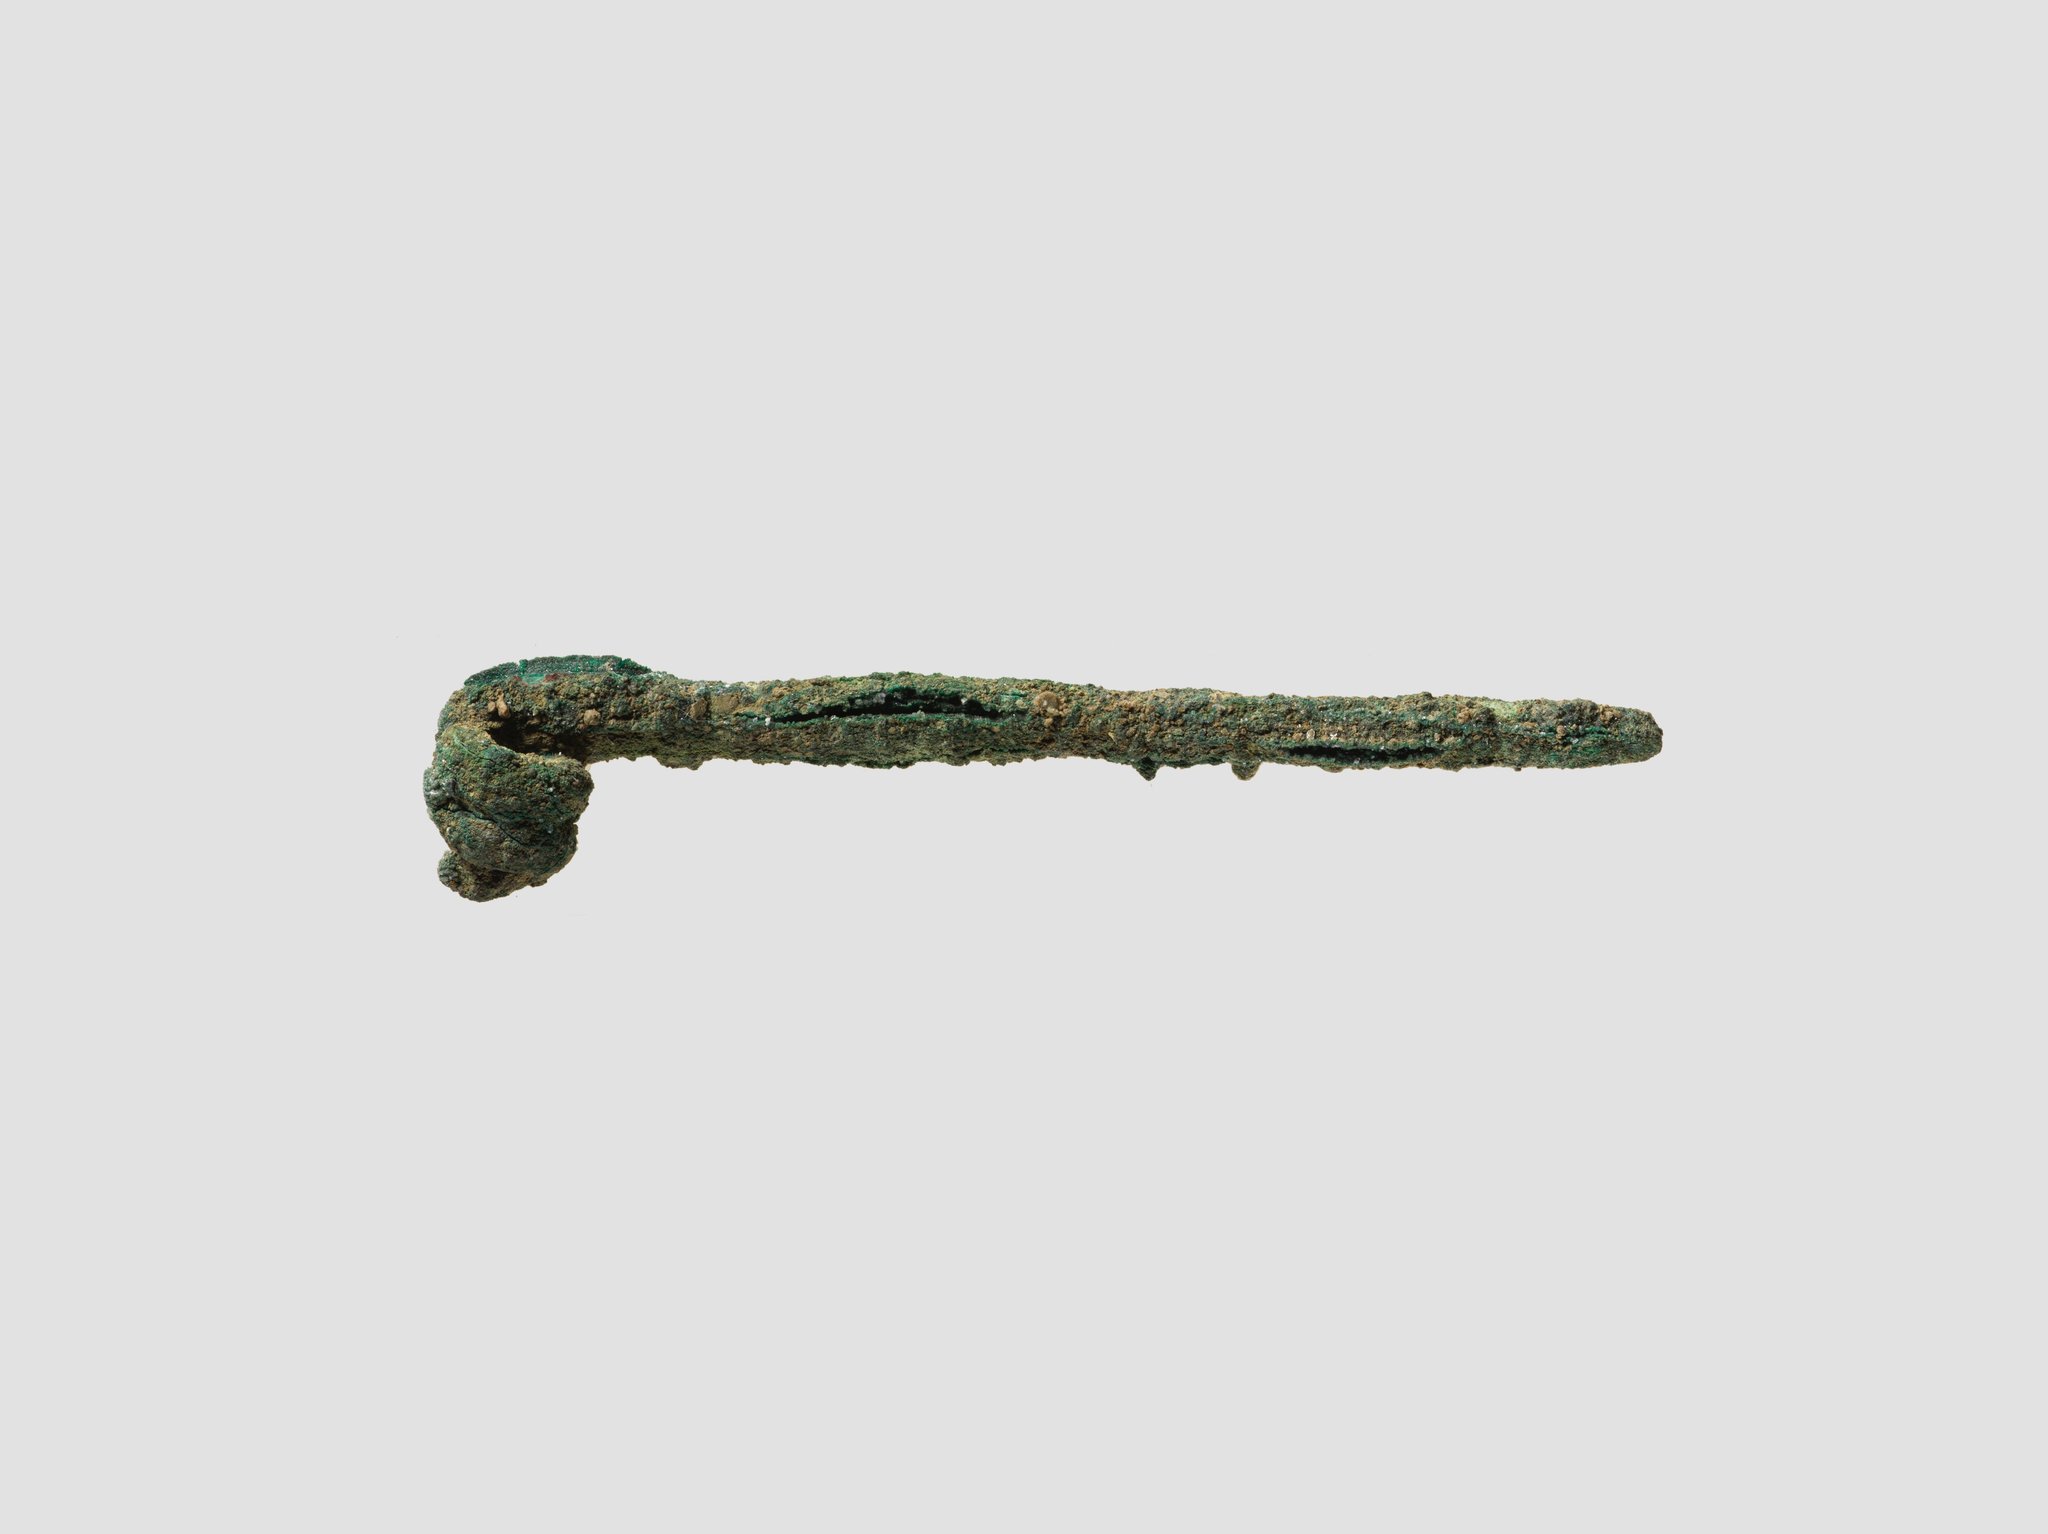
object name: fibula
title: Fibula pin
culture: iranian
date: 700-501 BCE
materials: bronze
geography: iran